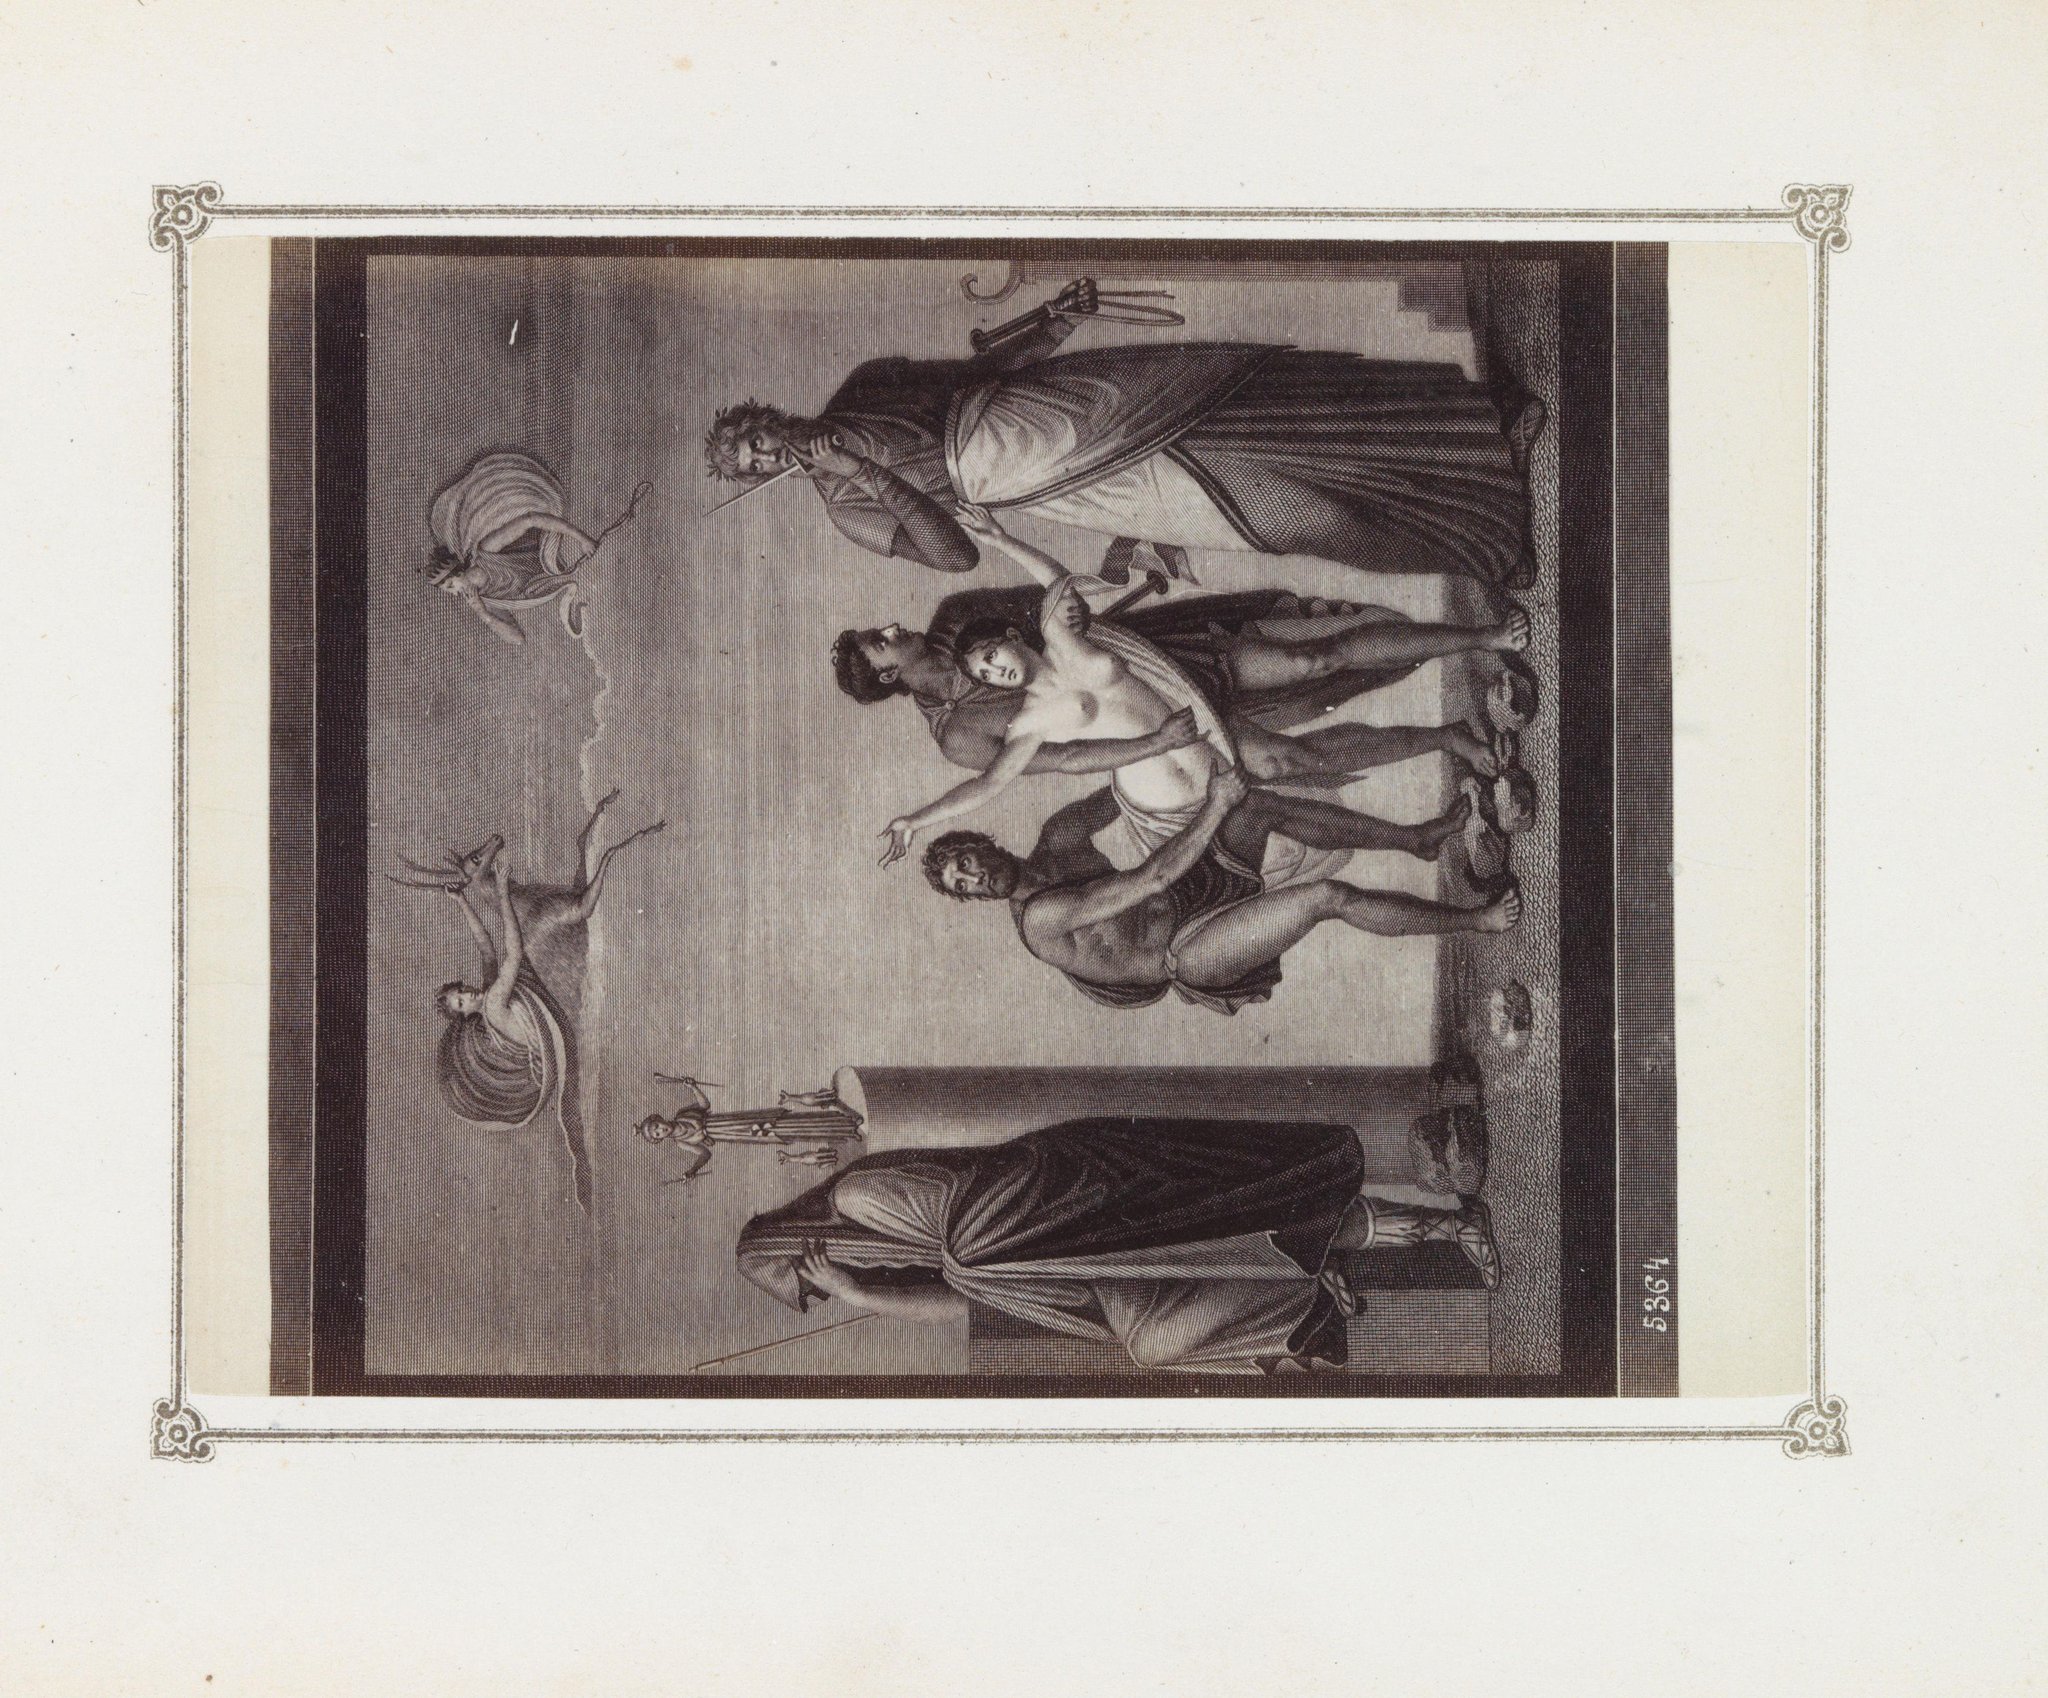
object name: reproduction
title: Fotoreproductie van (vermoedelijk) een prent naar een muurschildering in Pompeï, voorstellend een offerscène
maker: giorgio sommer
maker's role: fotograaf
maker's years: 1834-1914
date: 1860-1900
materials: paper, photographic support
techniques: albumen print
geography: pompeii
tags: human sacrifice ~ roman religion, pompeii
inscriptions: number: ‘5381’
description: Onderdeel van Fotoalbum met opnames van opgravingen in Pompeï door Giorgio Sommer.